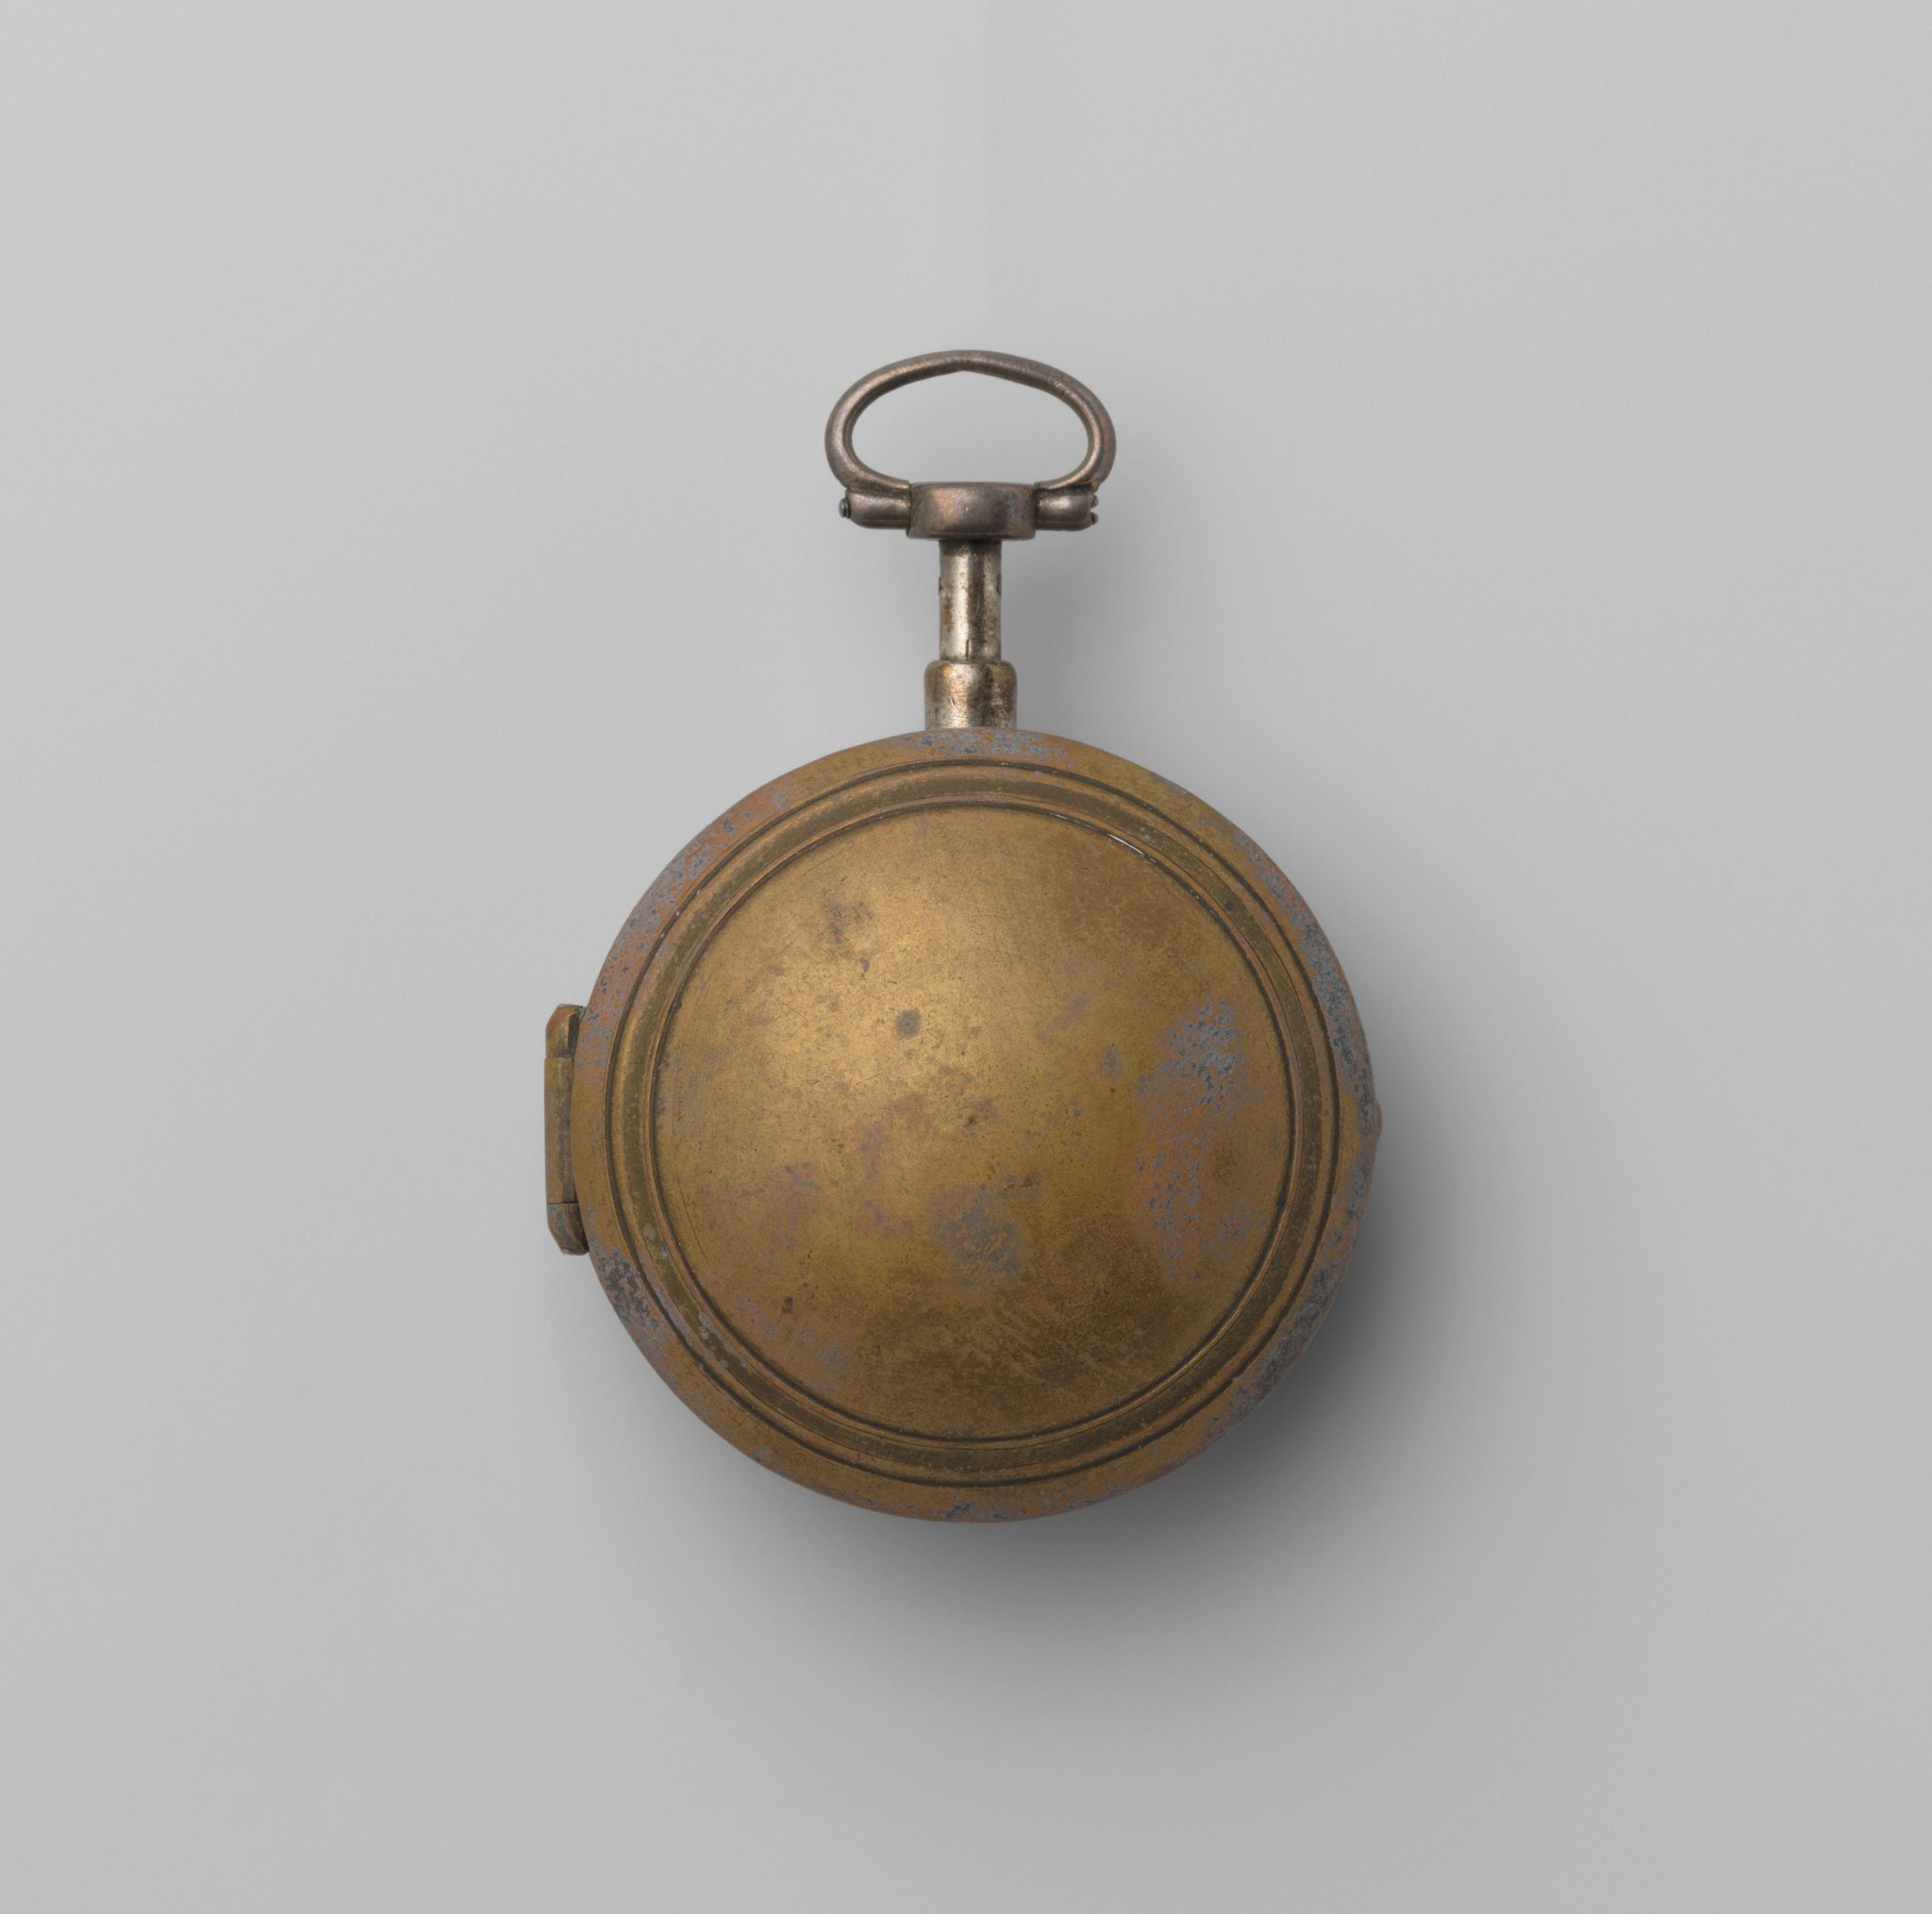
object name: wrist watch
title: Horloge, verzilverd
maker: regnault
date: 1798-1809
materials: copper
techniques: silvering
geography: france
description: Verzilverd koperen repetitie horloge met een geëmailleerde wijzerplaat. Met gladde koperen buitenkant.